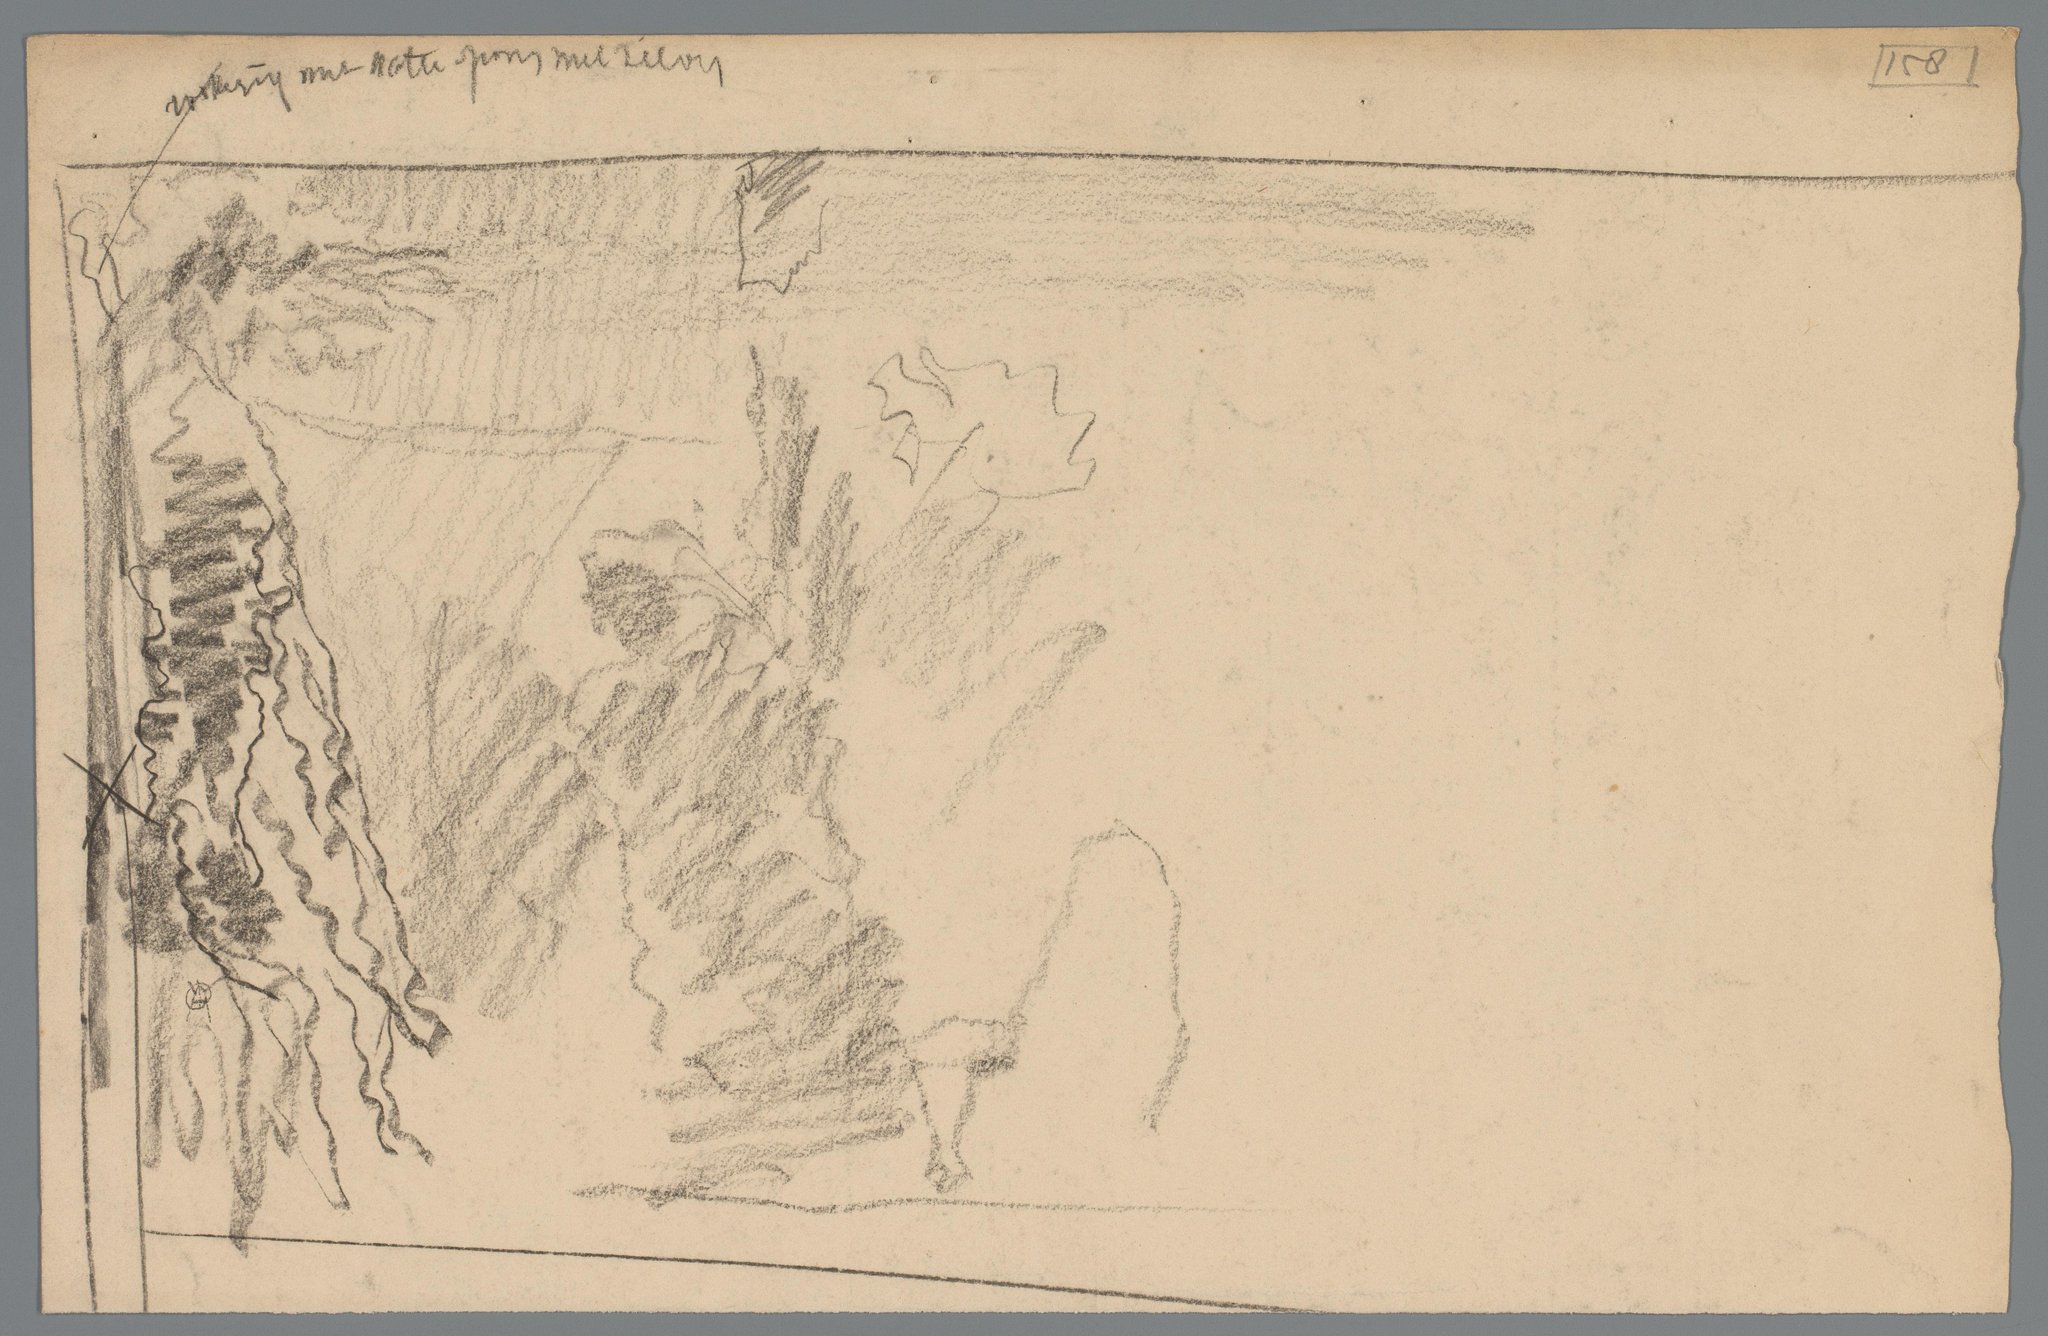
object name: drawing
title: Studie van een aquarium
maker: gerrit willem dijsselhof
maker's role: designer, draughtsman, print maker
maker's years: 1866-1924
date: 1876-1924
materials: chalk, paper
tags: aquarium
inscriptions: number: ‘158’